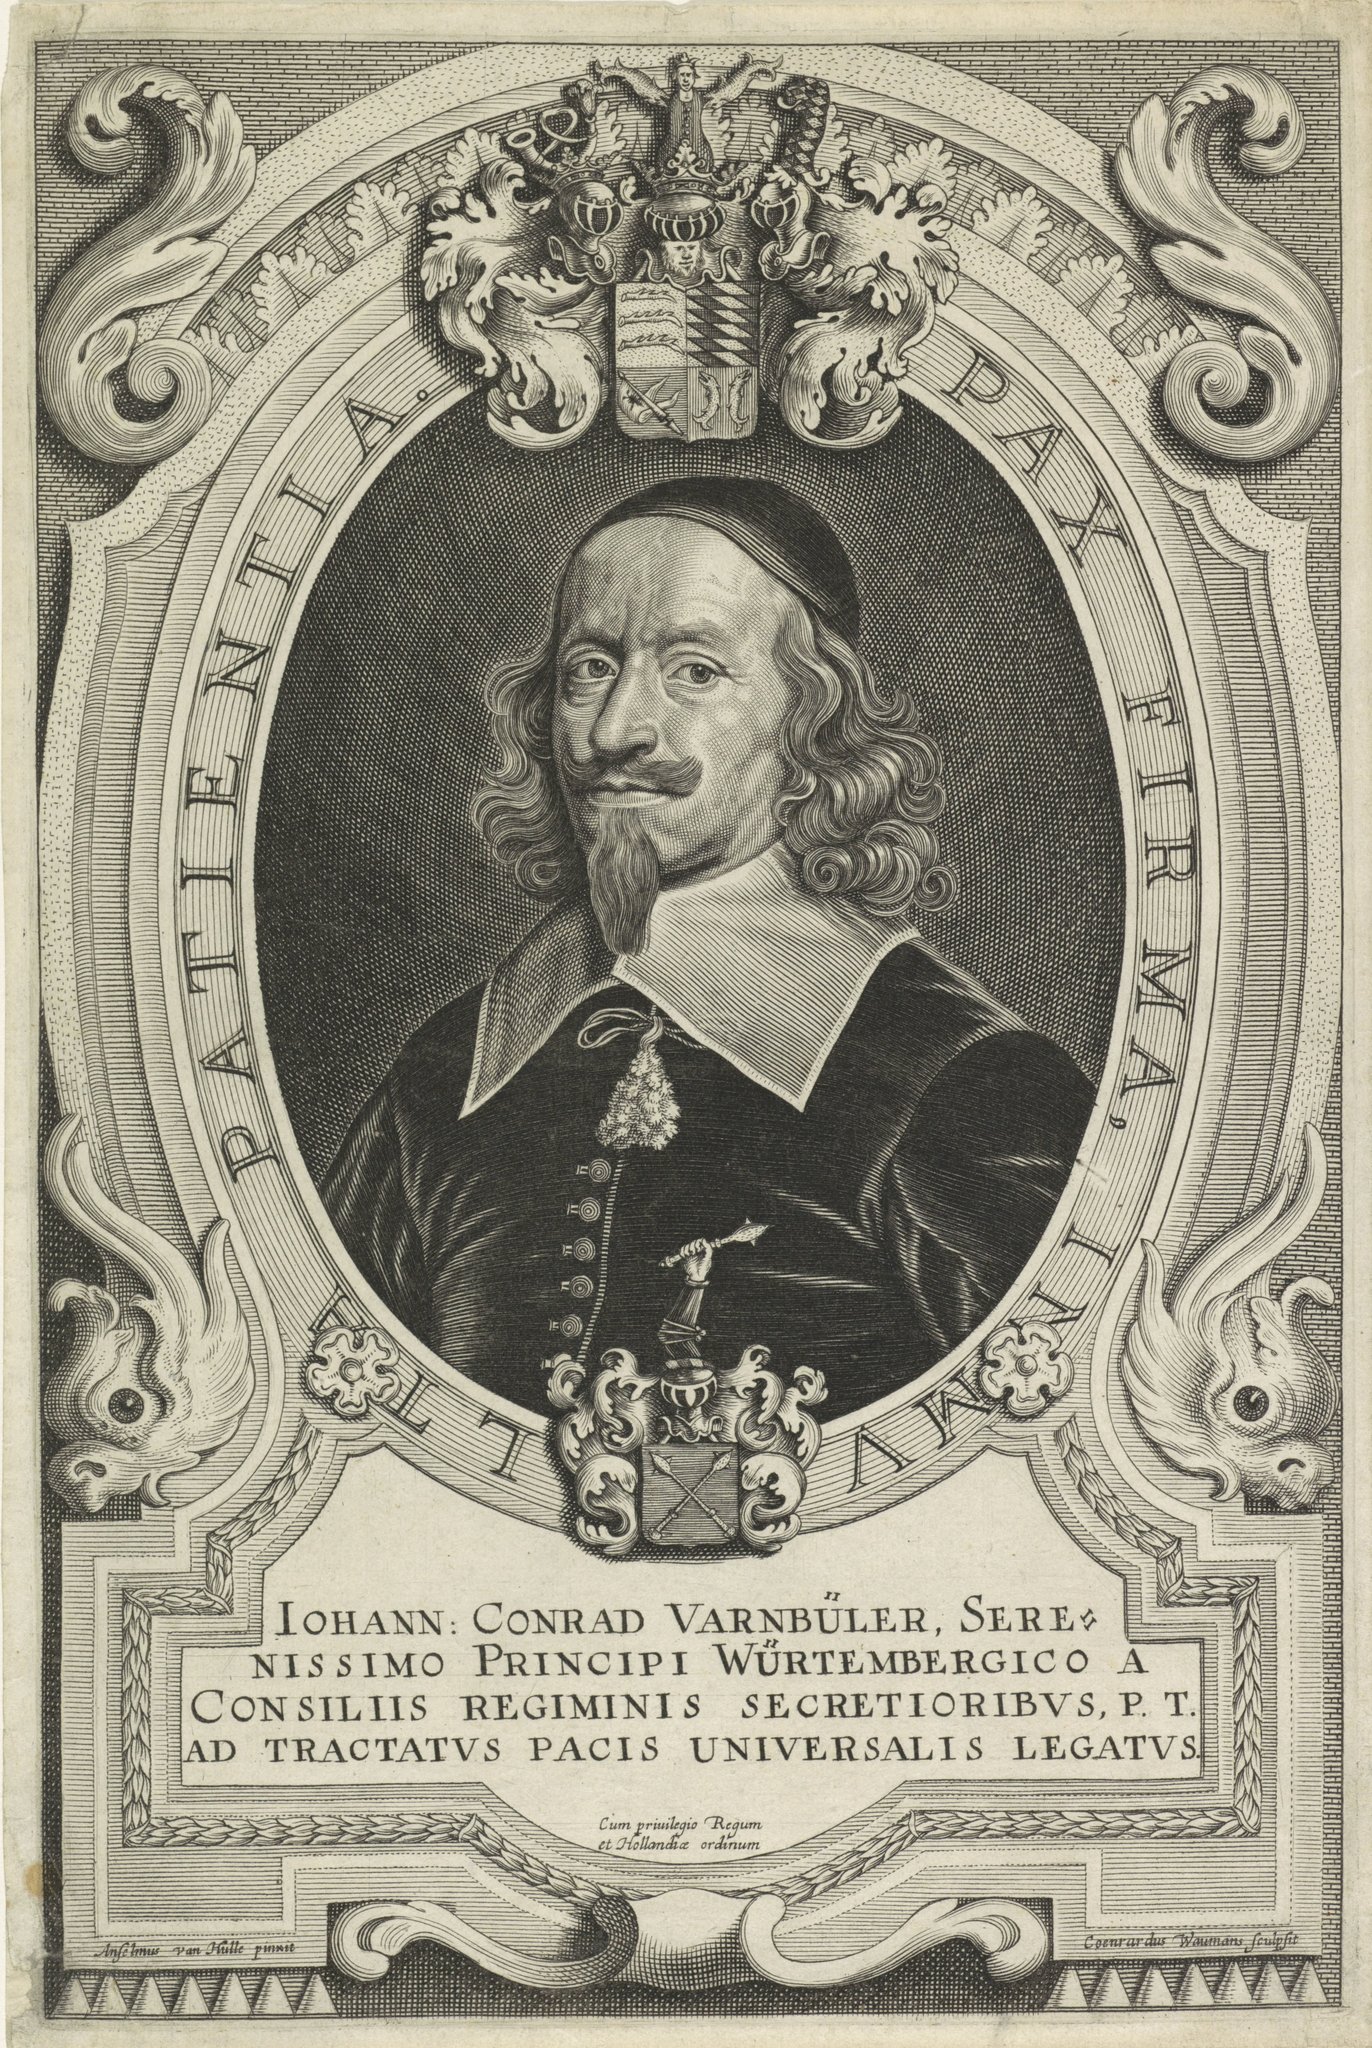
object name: print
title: Portret van Johann Konrad Varnbüler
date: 1648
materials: paper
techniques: engraving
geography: antwerp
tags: politician, armorial bearing, heraldry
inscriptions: collector's mark: Lugt 2228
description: Portret van Johann Konrad Varnbüler, in een ovale omlijsting met een randschrift in het Latijn, bekroond met een wapenschild. In het kader een vierregelig onderschrift in het Latijn.